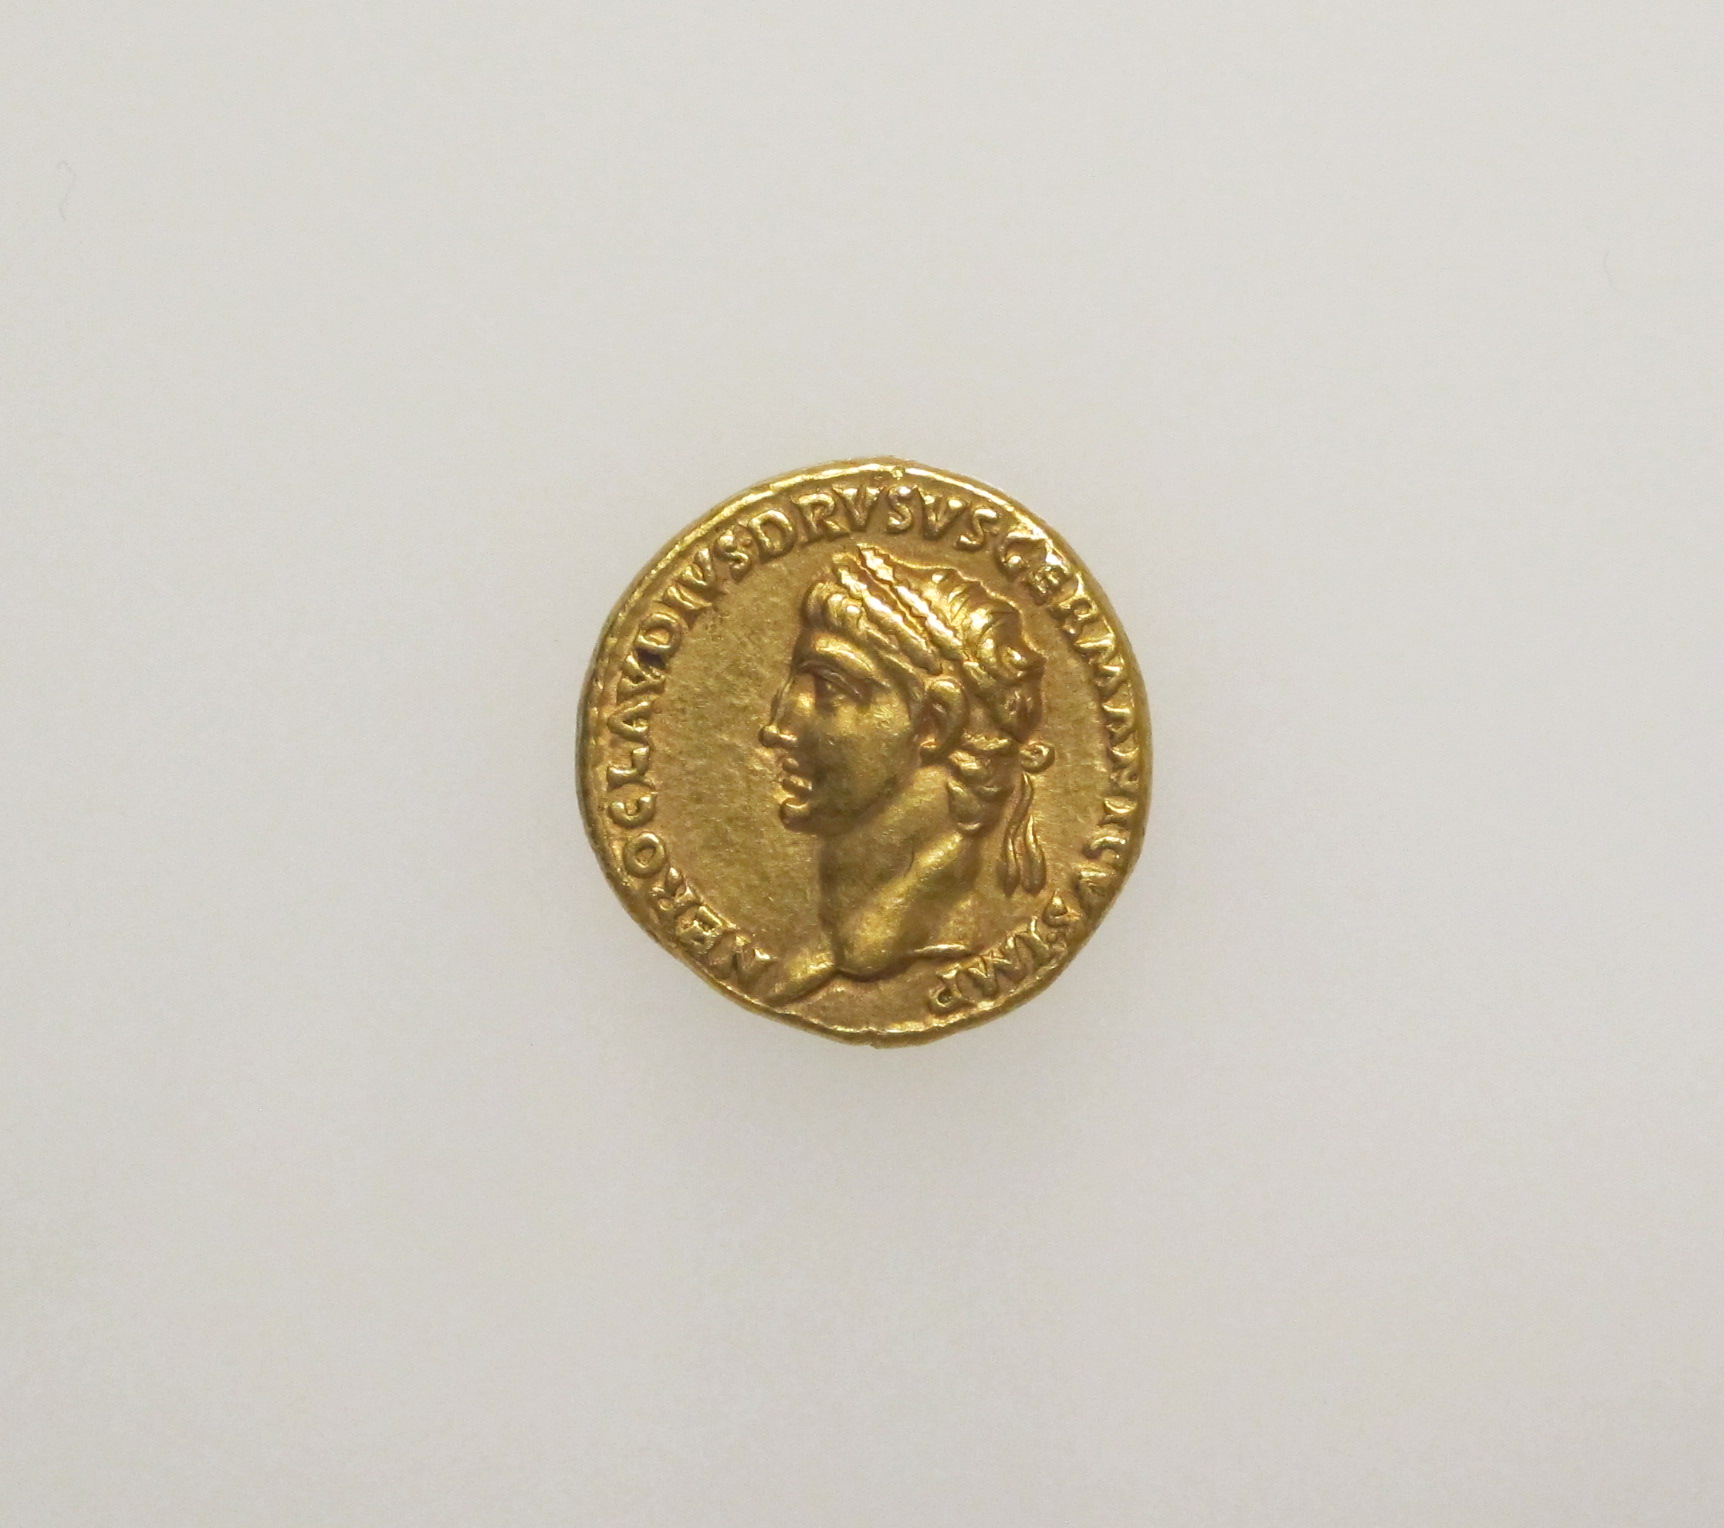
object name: aureus of nero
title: Gold aureus of Claudius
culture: roman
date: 41-45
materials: gold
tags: men,profiles,horses